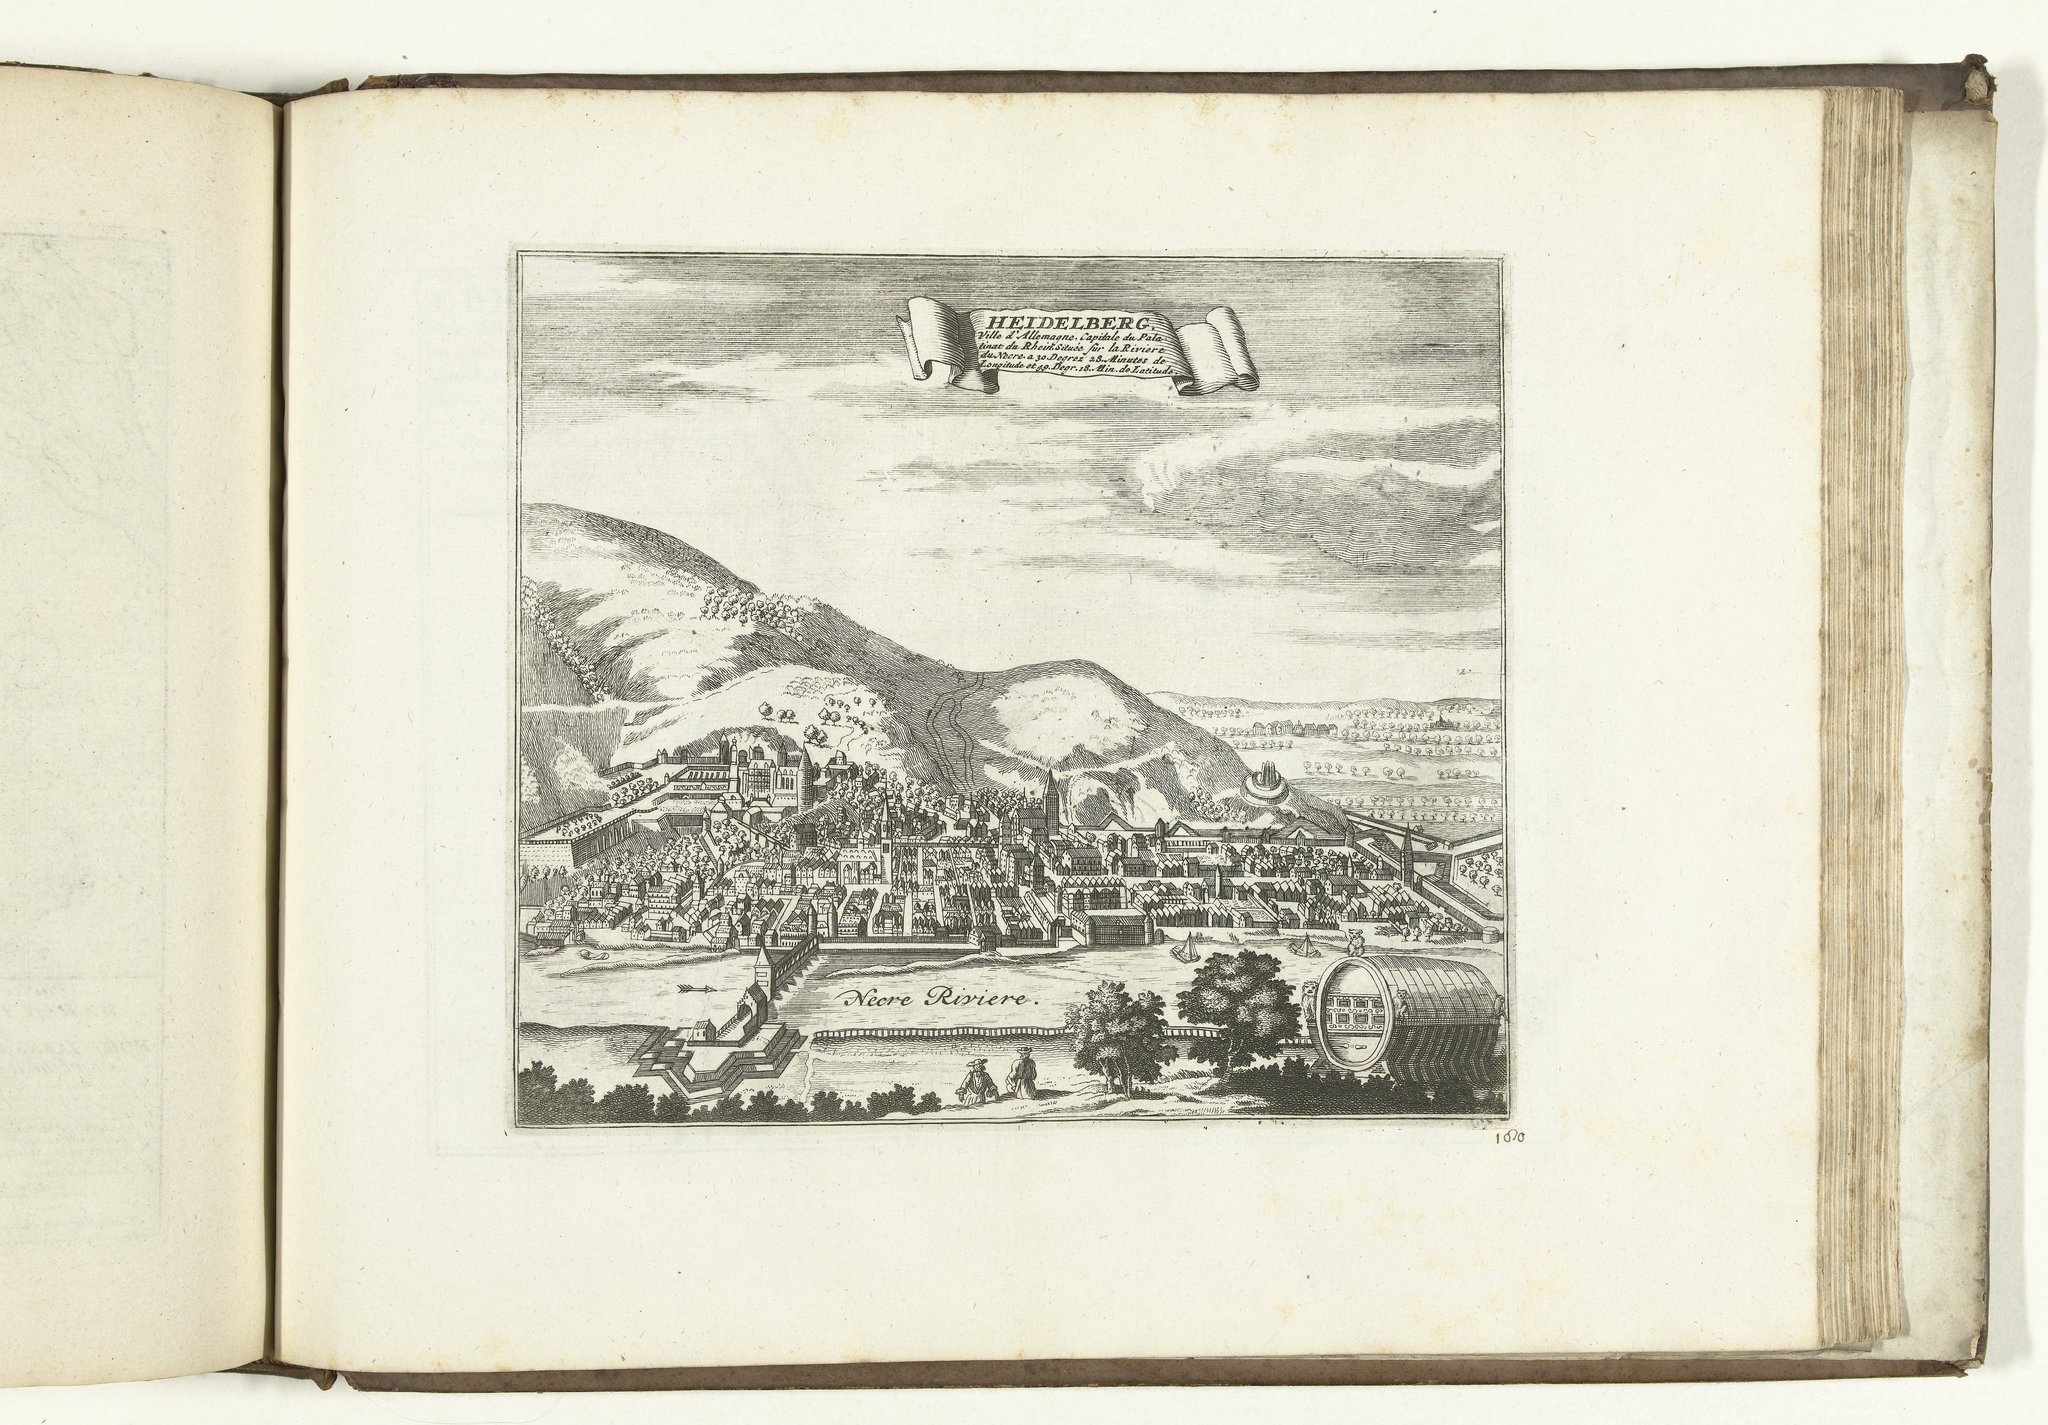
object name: print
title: Gezicht op Heidelberg, 1726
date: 1726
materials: paper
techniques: etching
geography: northern netherlands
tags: heidelberg, spaanse successieoorlog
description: Gezicht op de Duitse stad Heidelberg, op de voorgrond het grote vat. Plaat nr. 180 in deel VIII van het prentwerk: Les Forces de l'Europe, Asie, Afrique et Amerique ... Comme aussi les Cartes des Côtes de France et d'Espagne uit 1726, dit eerste deel met 238 met de hand genummerde platen van vermaarde sterke steden en vestingen in het kader van de Spaanse Successieoorlog 1701-1713. Voor het merendeel zijn deze platen gekopieerd naar de anonieme Franse platen van vermaarde sterke steden en vestingen: in Les forces de l'Europe en in: Le theatre de la guerre, dans les Pays-Bas, beide oorspronkelijk uitgegeven door Nicolas de Fer te Parijs (1693-1697) in het kader van de Negenjarige Oorlog. Titels en opschriften in het Frans. Rechtsonder sporen van het weggepolijste nummer: 97.